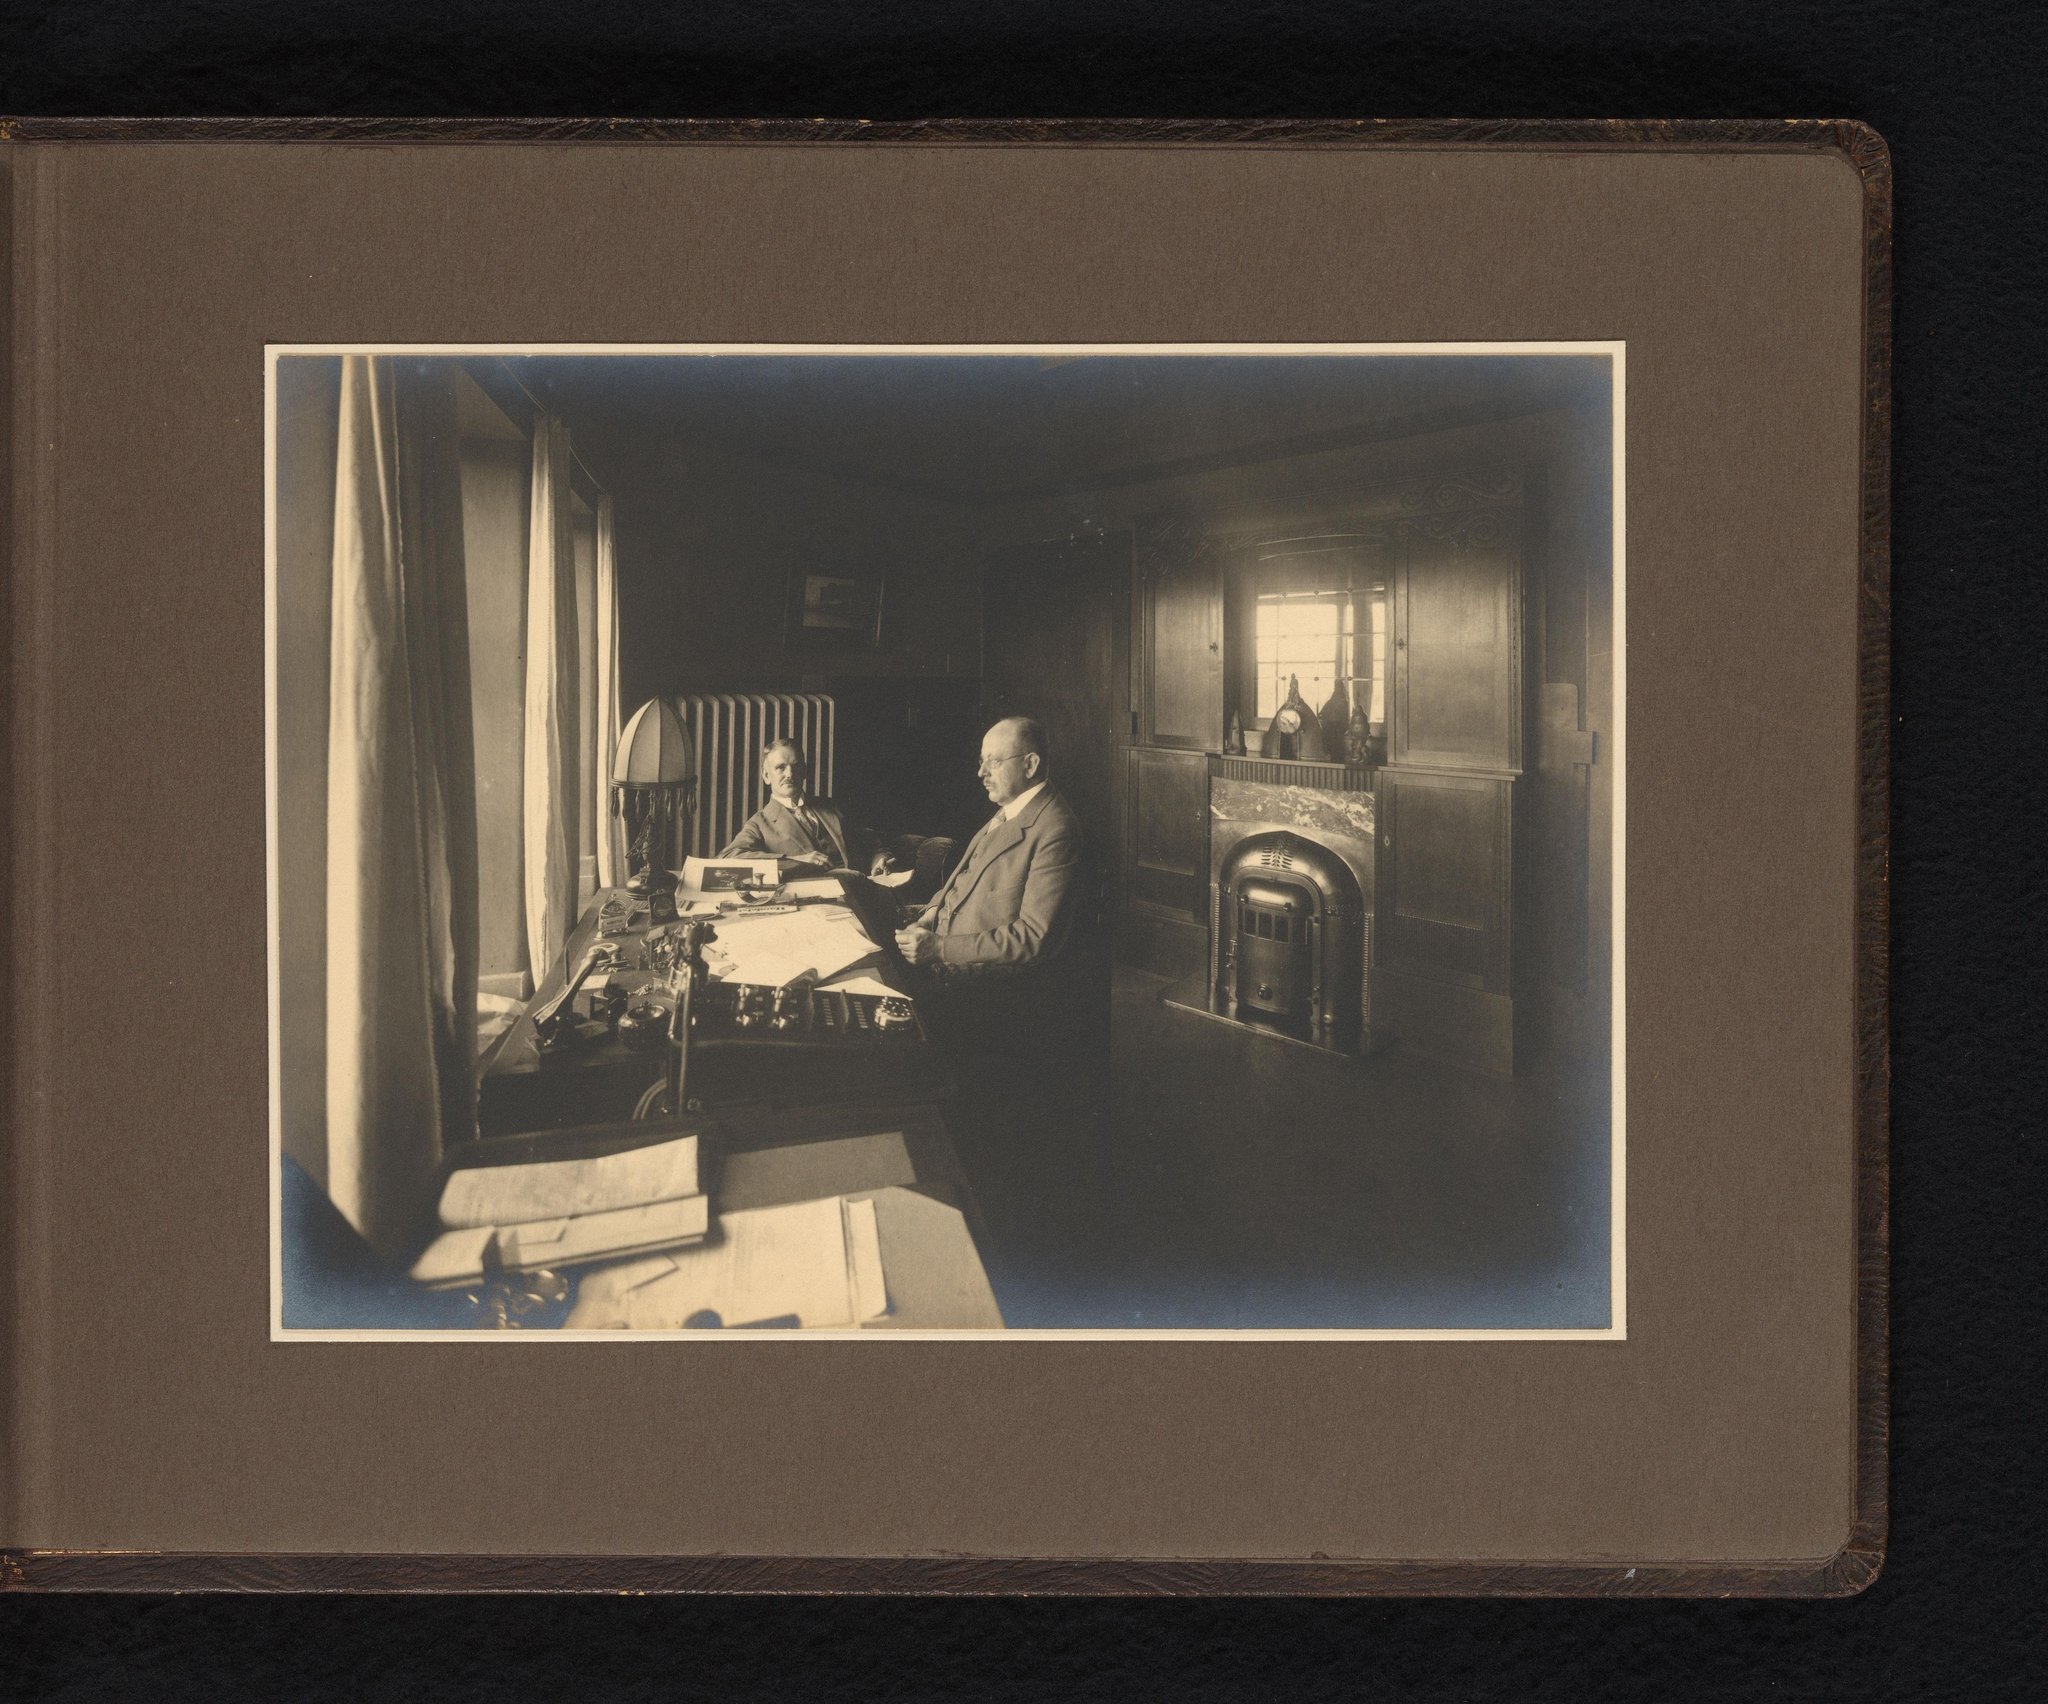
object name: album leaf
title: Twee mannen aan een bureau in een kantoor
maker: Anonymous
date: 1900-1930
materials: cardboard, paper, photographic support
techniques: gelatin silver print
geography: amsterdam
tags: writing-table, writing-desk, adult man (+ two persons), office (~ administration), amsterdam